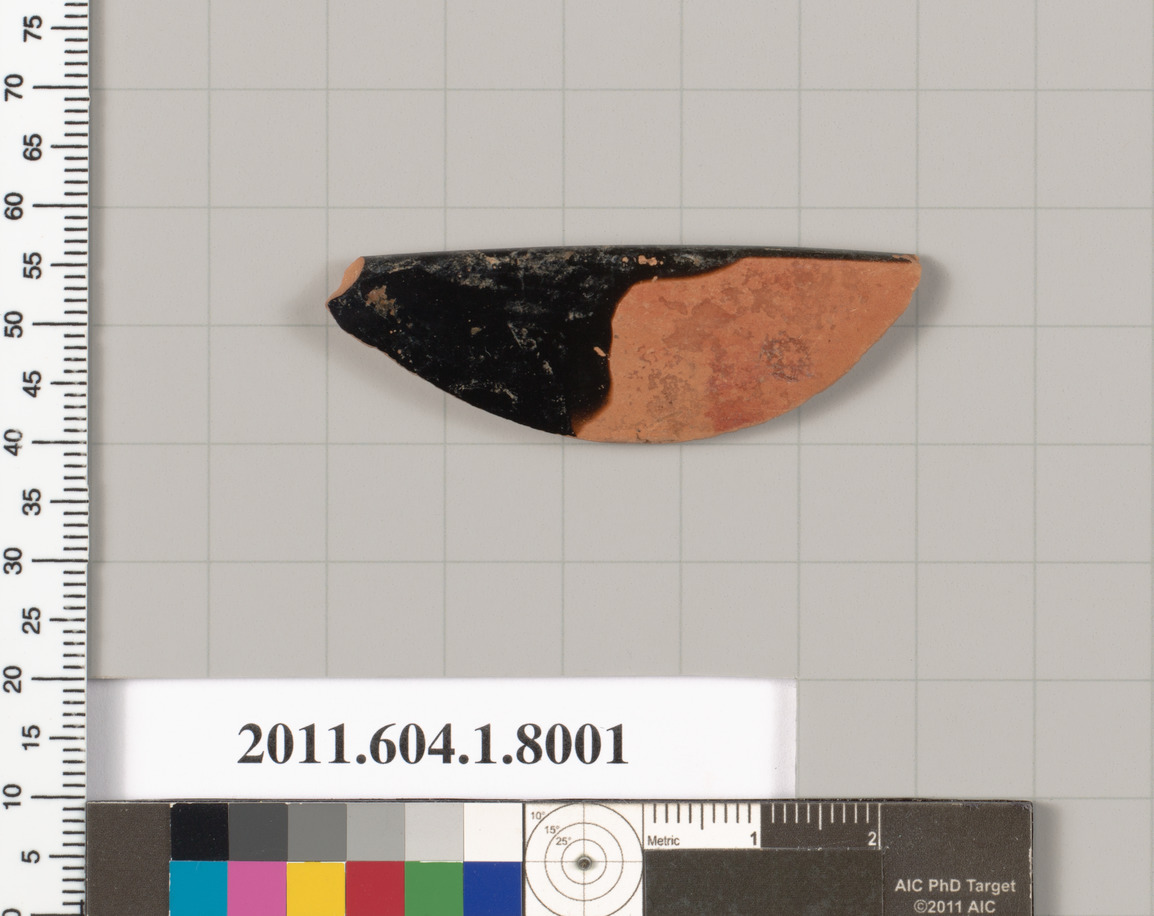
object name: kylix fragment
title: Terracotta rim fragment of a kylix (drinking cup)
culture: greek, attic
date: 460-450 BCE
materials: terracotta